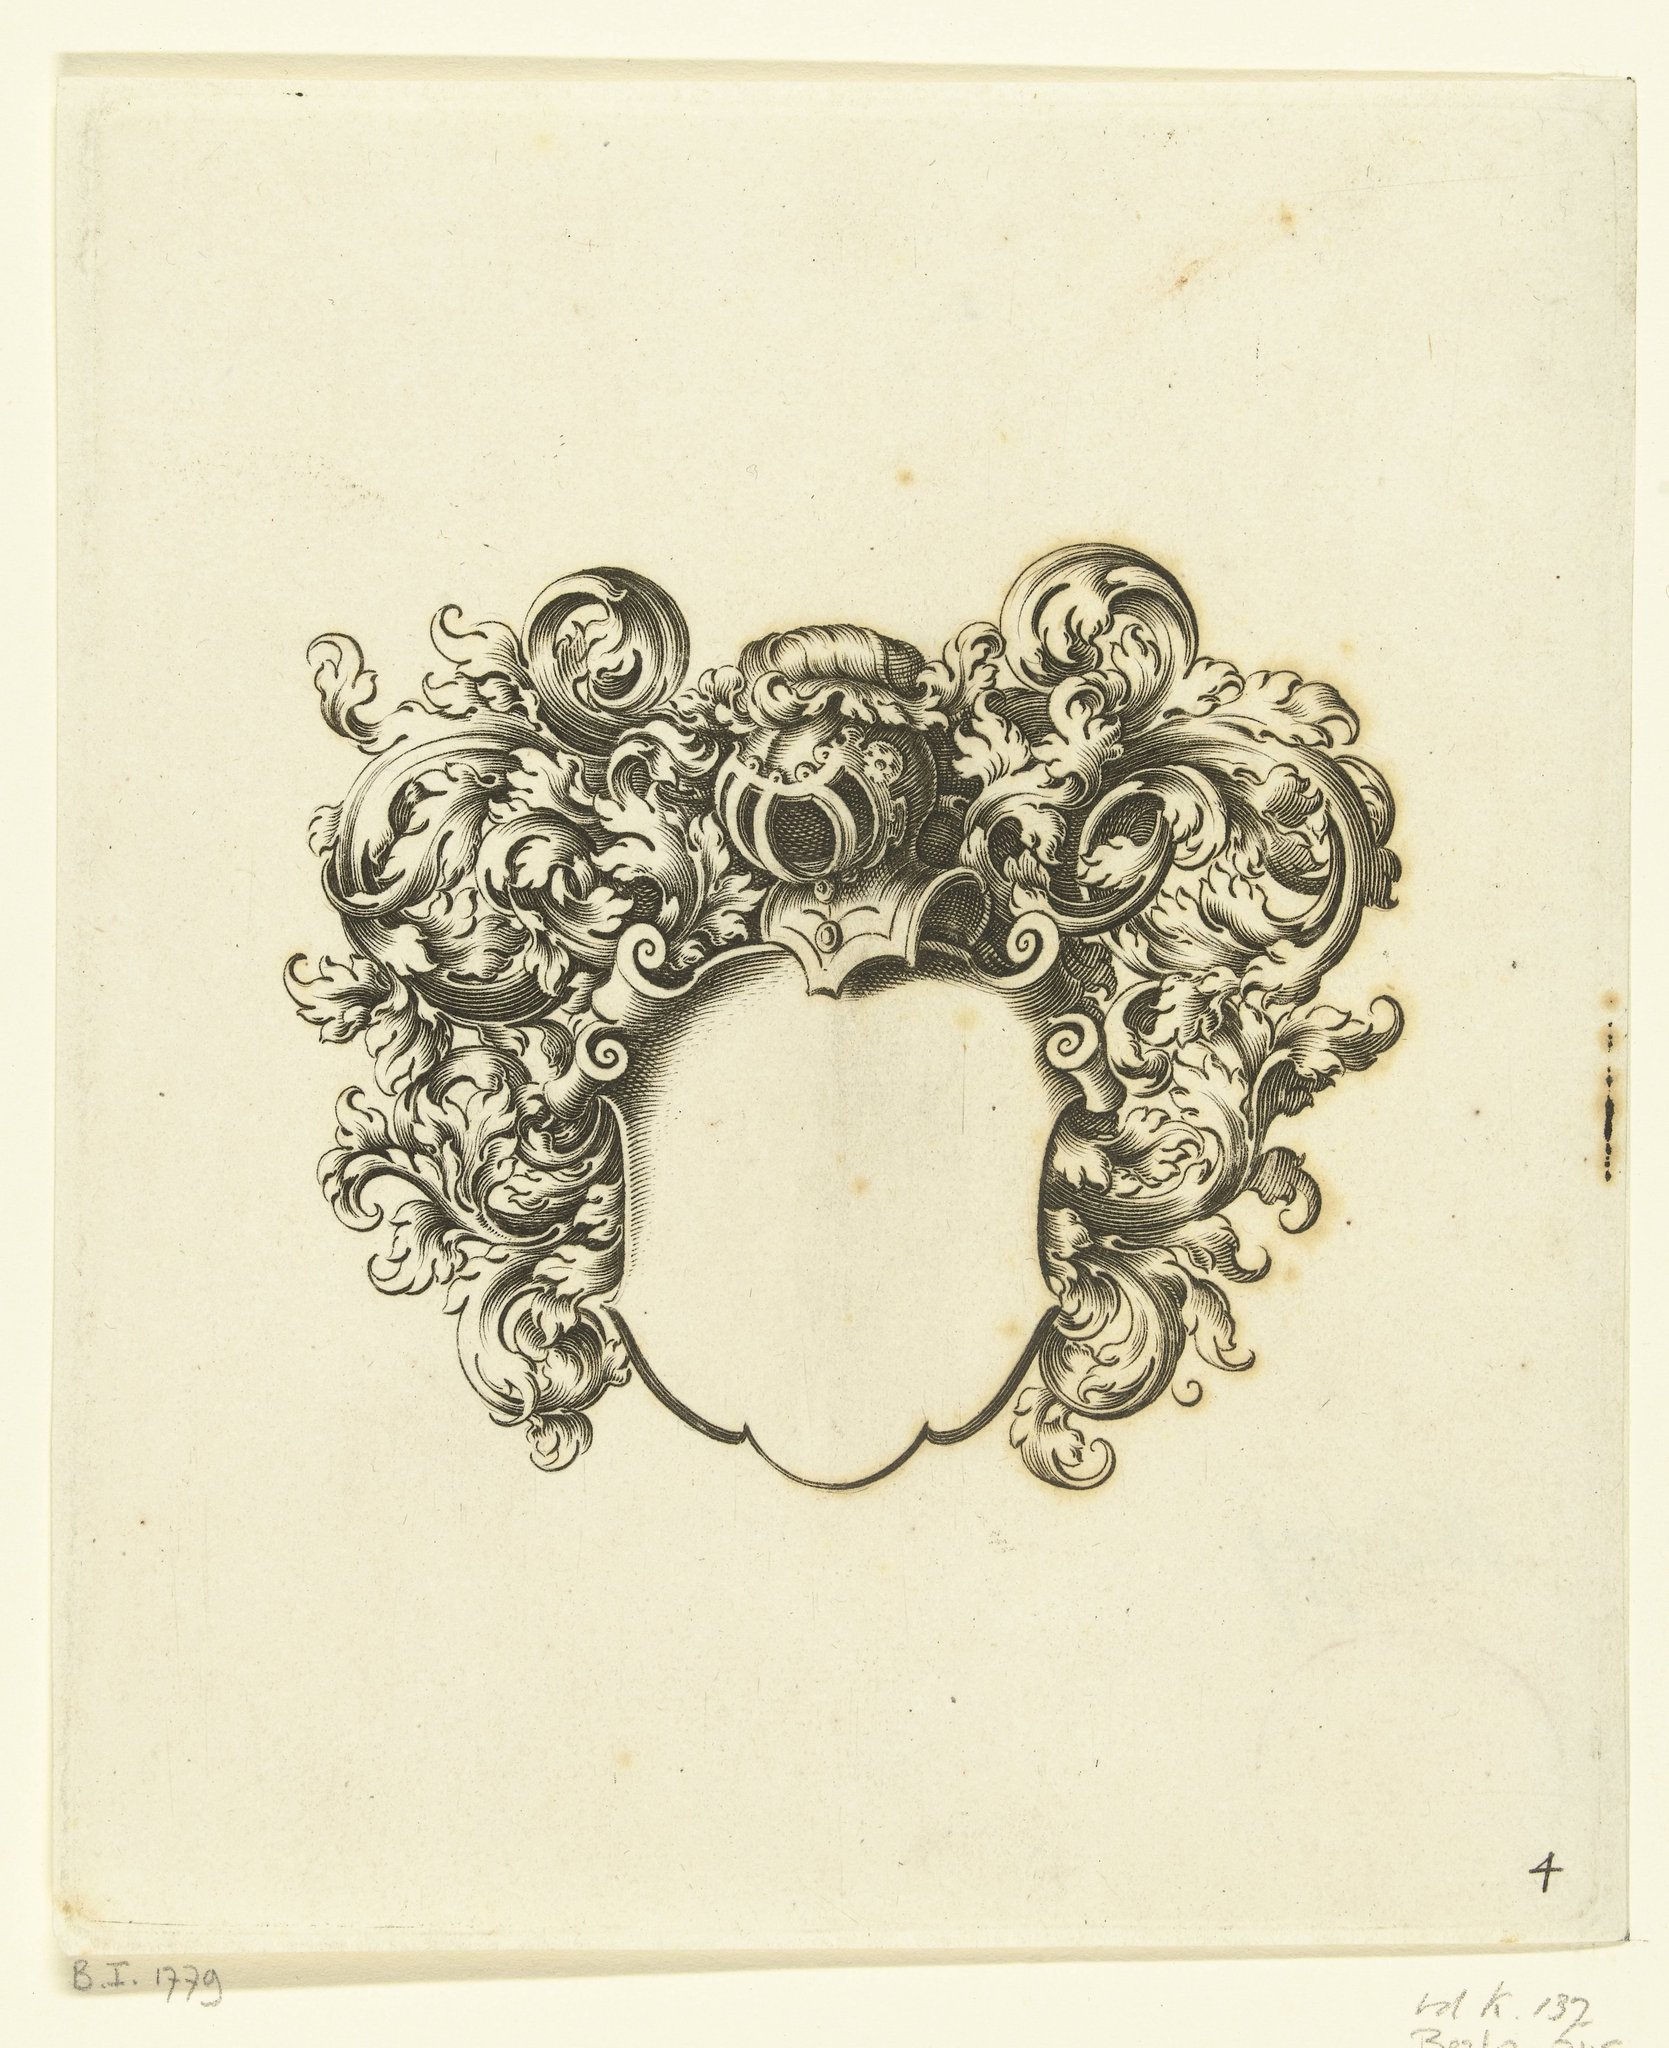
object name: print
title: Wapenschild van Minema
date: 1612-1625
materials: paper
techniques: engraving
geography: amsterdam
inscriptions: collector's mark: Lugt 240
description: Tegenzijdige kopie, zonder de leeuw op de helm en met een leeg schild.